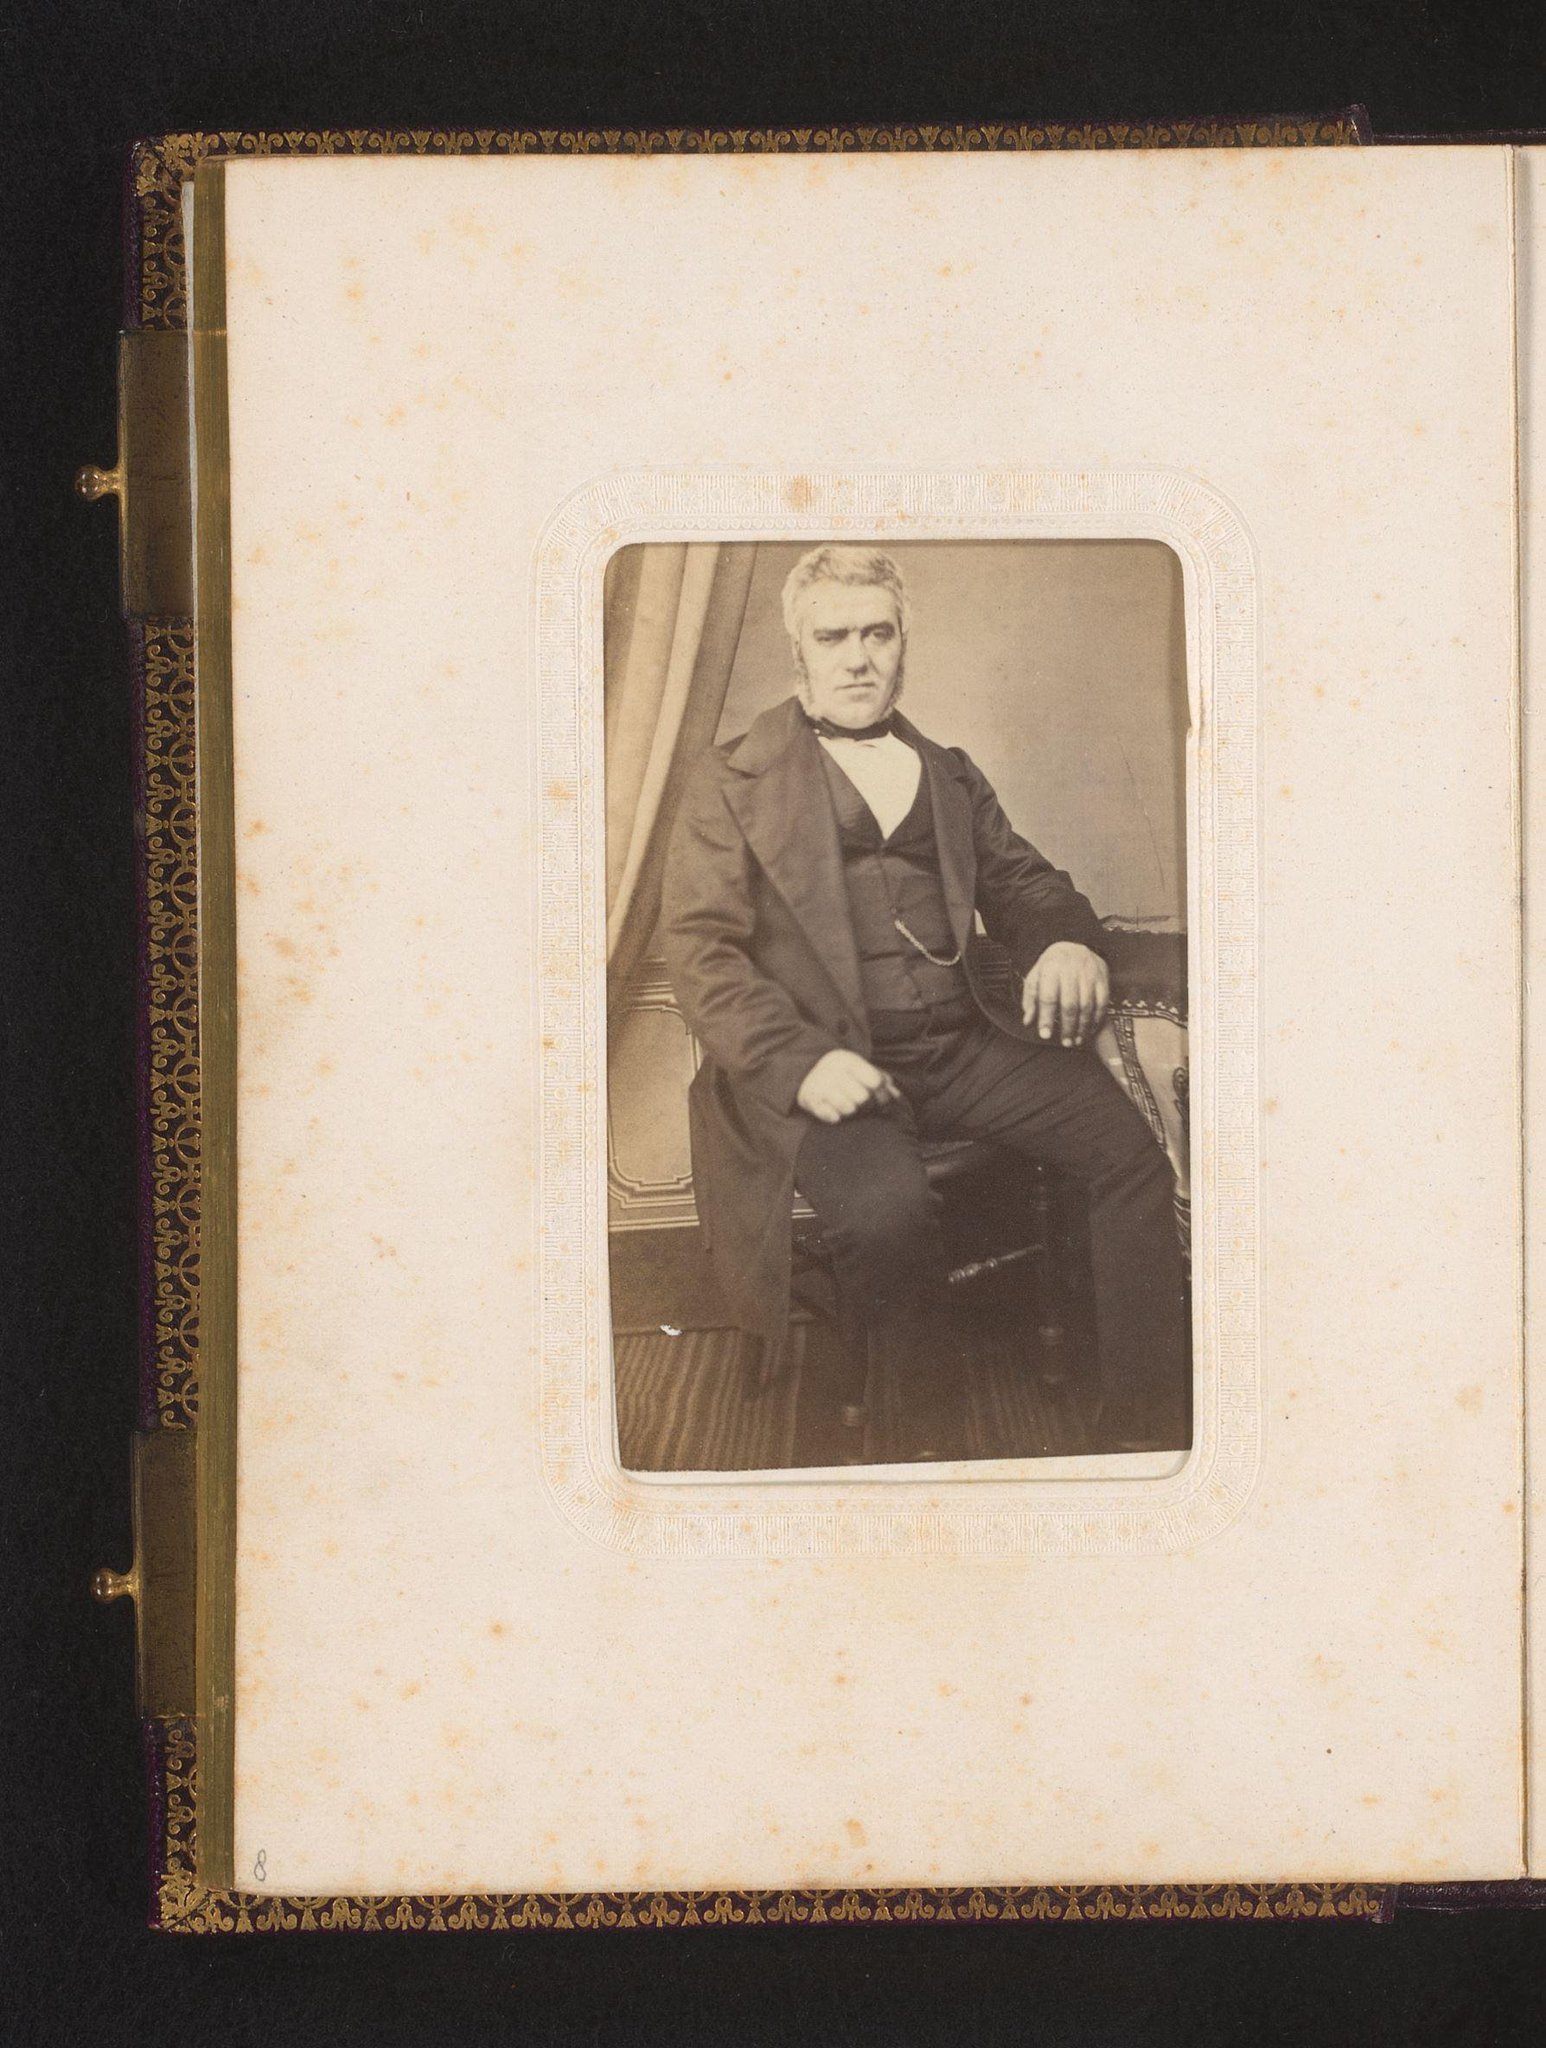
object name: photograph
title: Portret van een zittende man met bakkebaarden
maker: Anonymous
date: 1860-1900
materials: cardboard, photographic support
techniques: albumen print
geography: france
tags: sideburns, sitting figure, historical persons